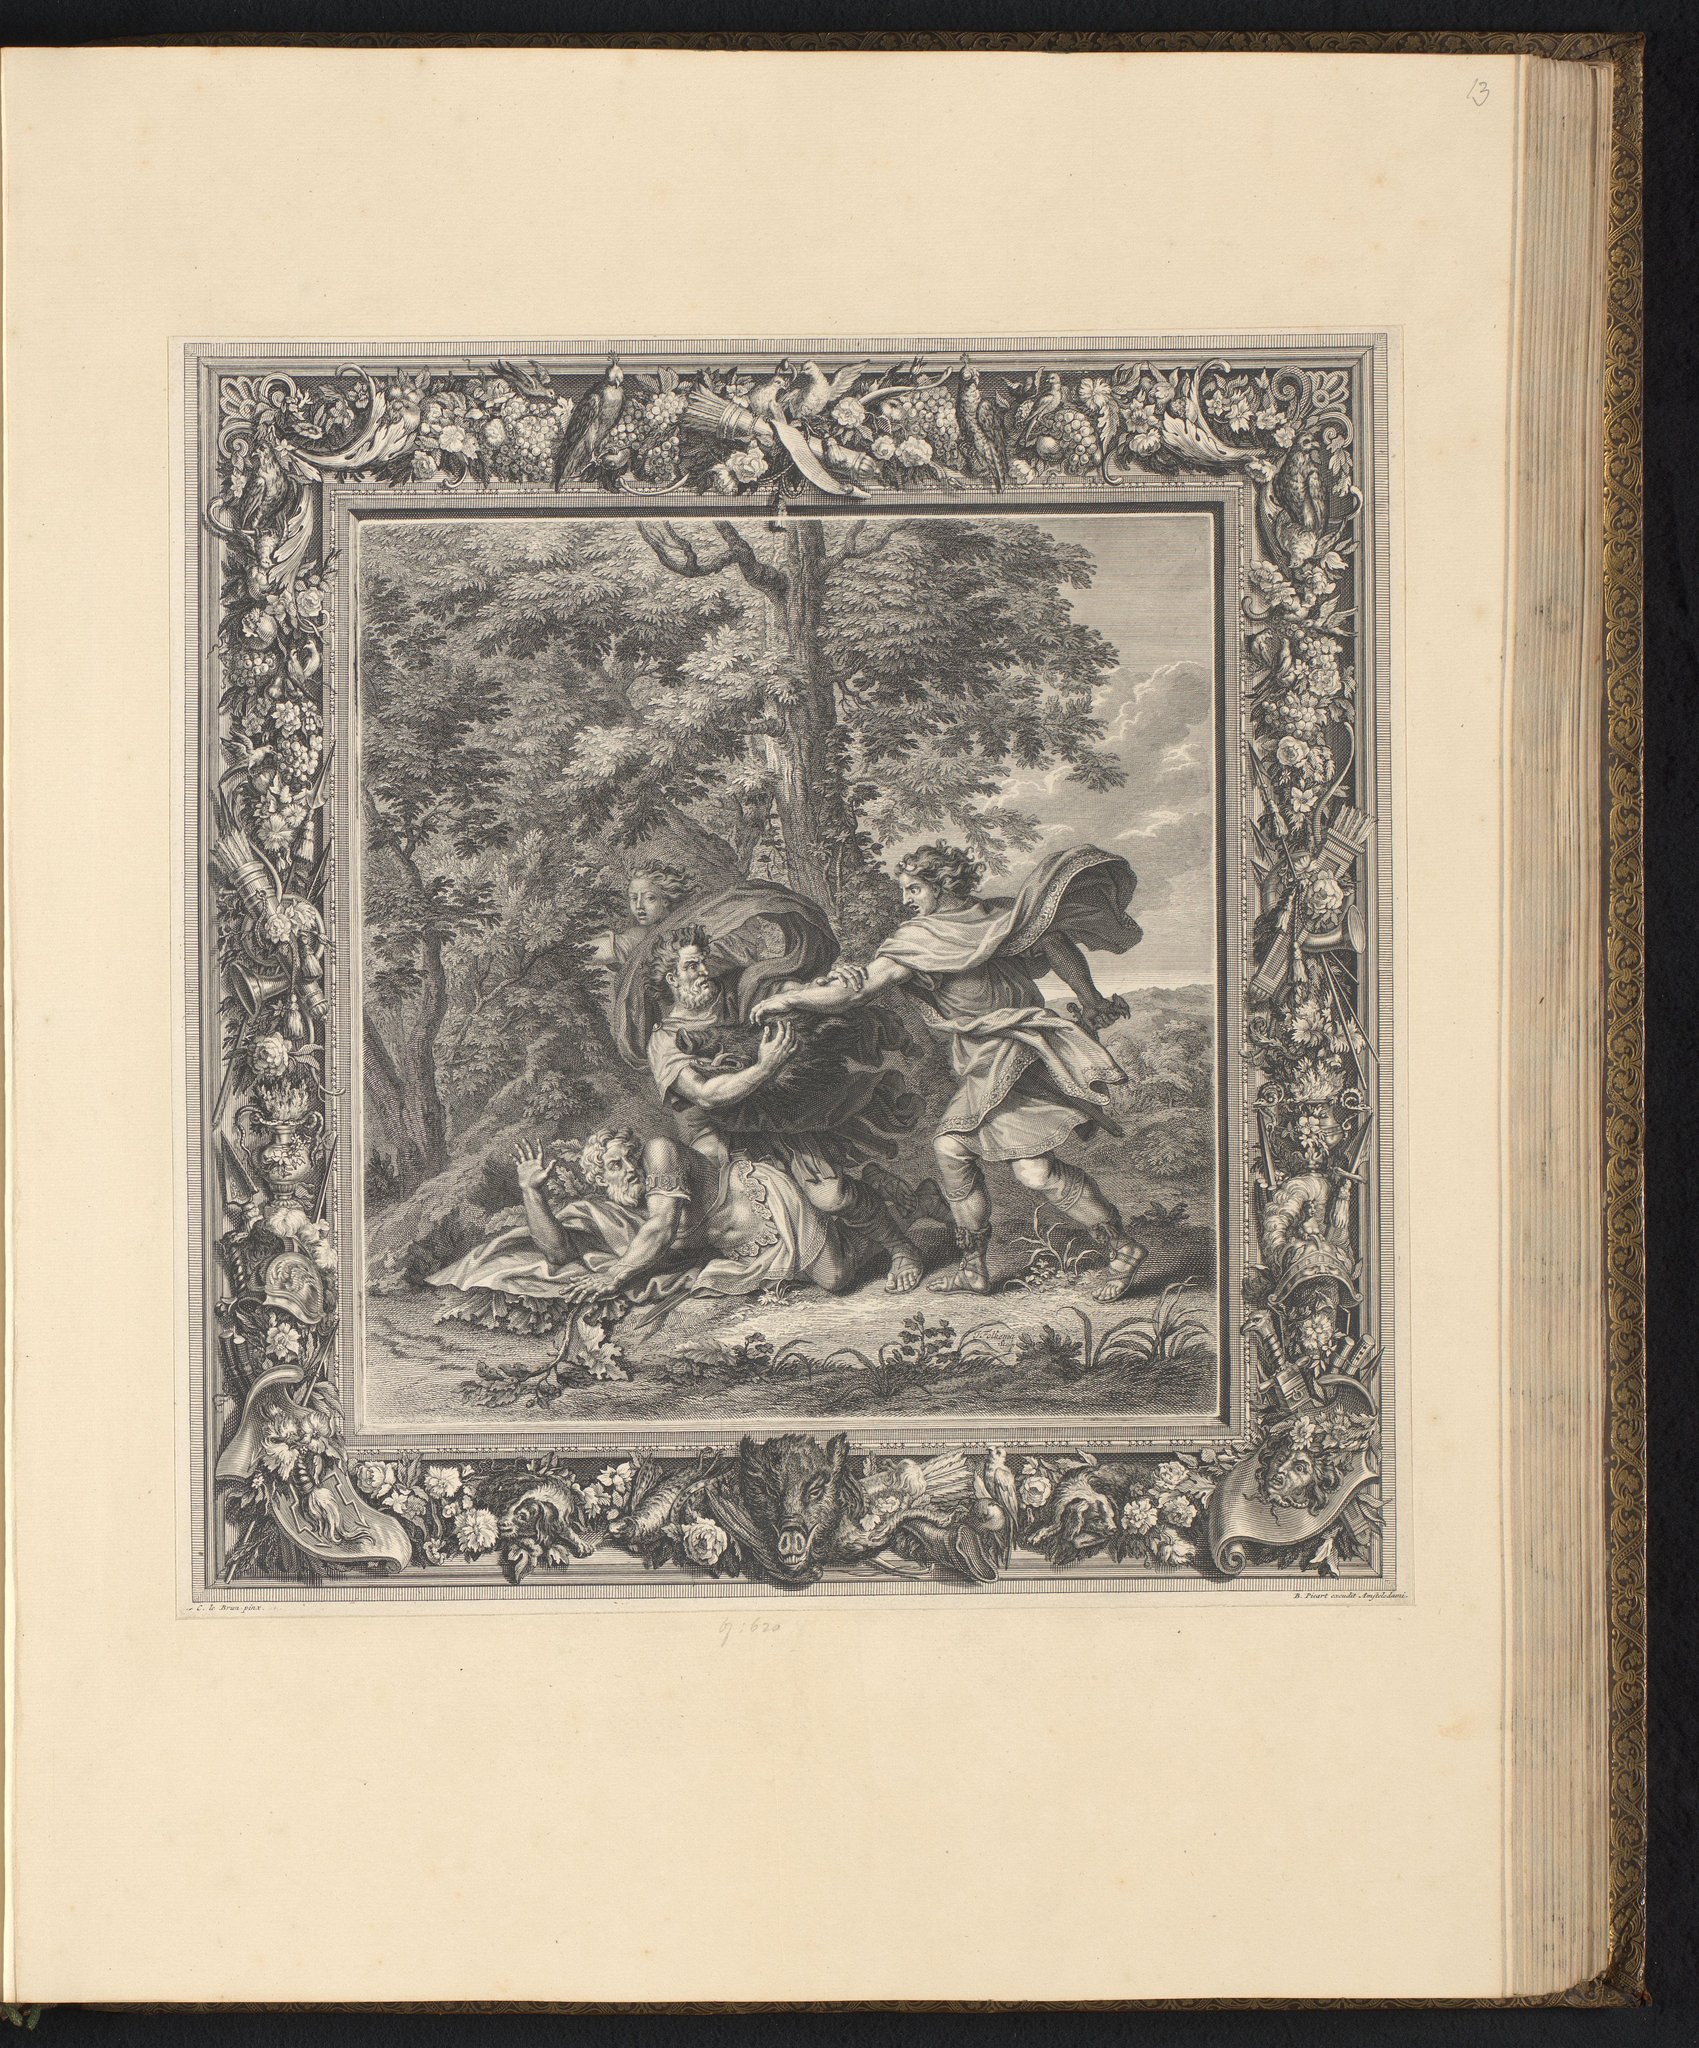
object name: album leaf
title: Mythe van Meleager in wandtapijten uitgebeeld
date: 1714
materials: paper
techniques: engraving, etching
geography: amsterdam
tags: meleager kills two of his uncles, when they object to the gift of the boar's head to atalante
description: In een decoratieve rand met thema's gerelateerd aan het verhaal van Meleager. Deze prent maakt deel uit van een album.